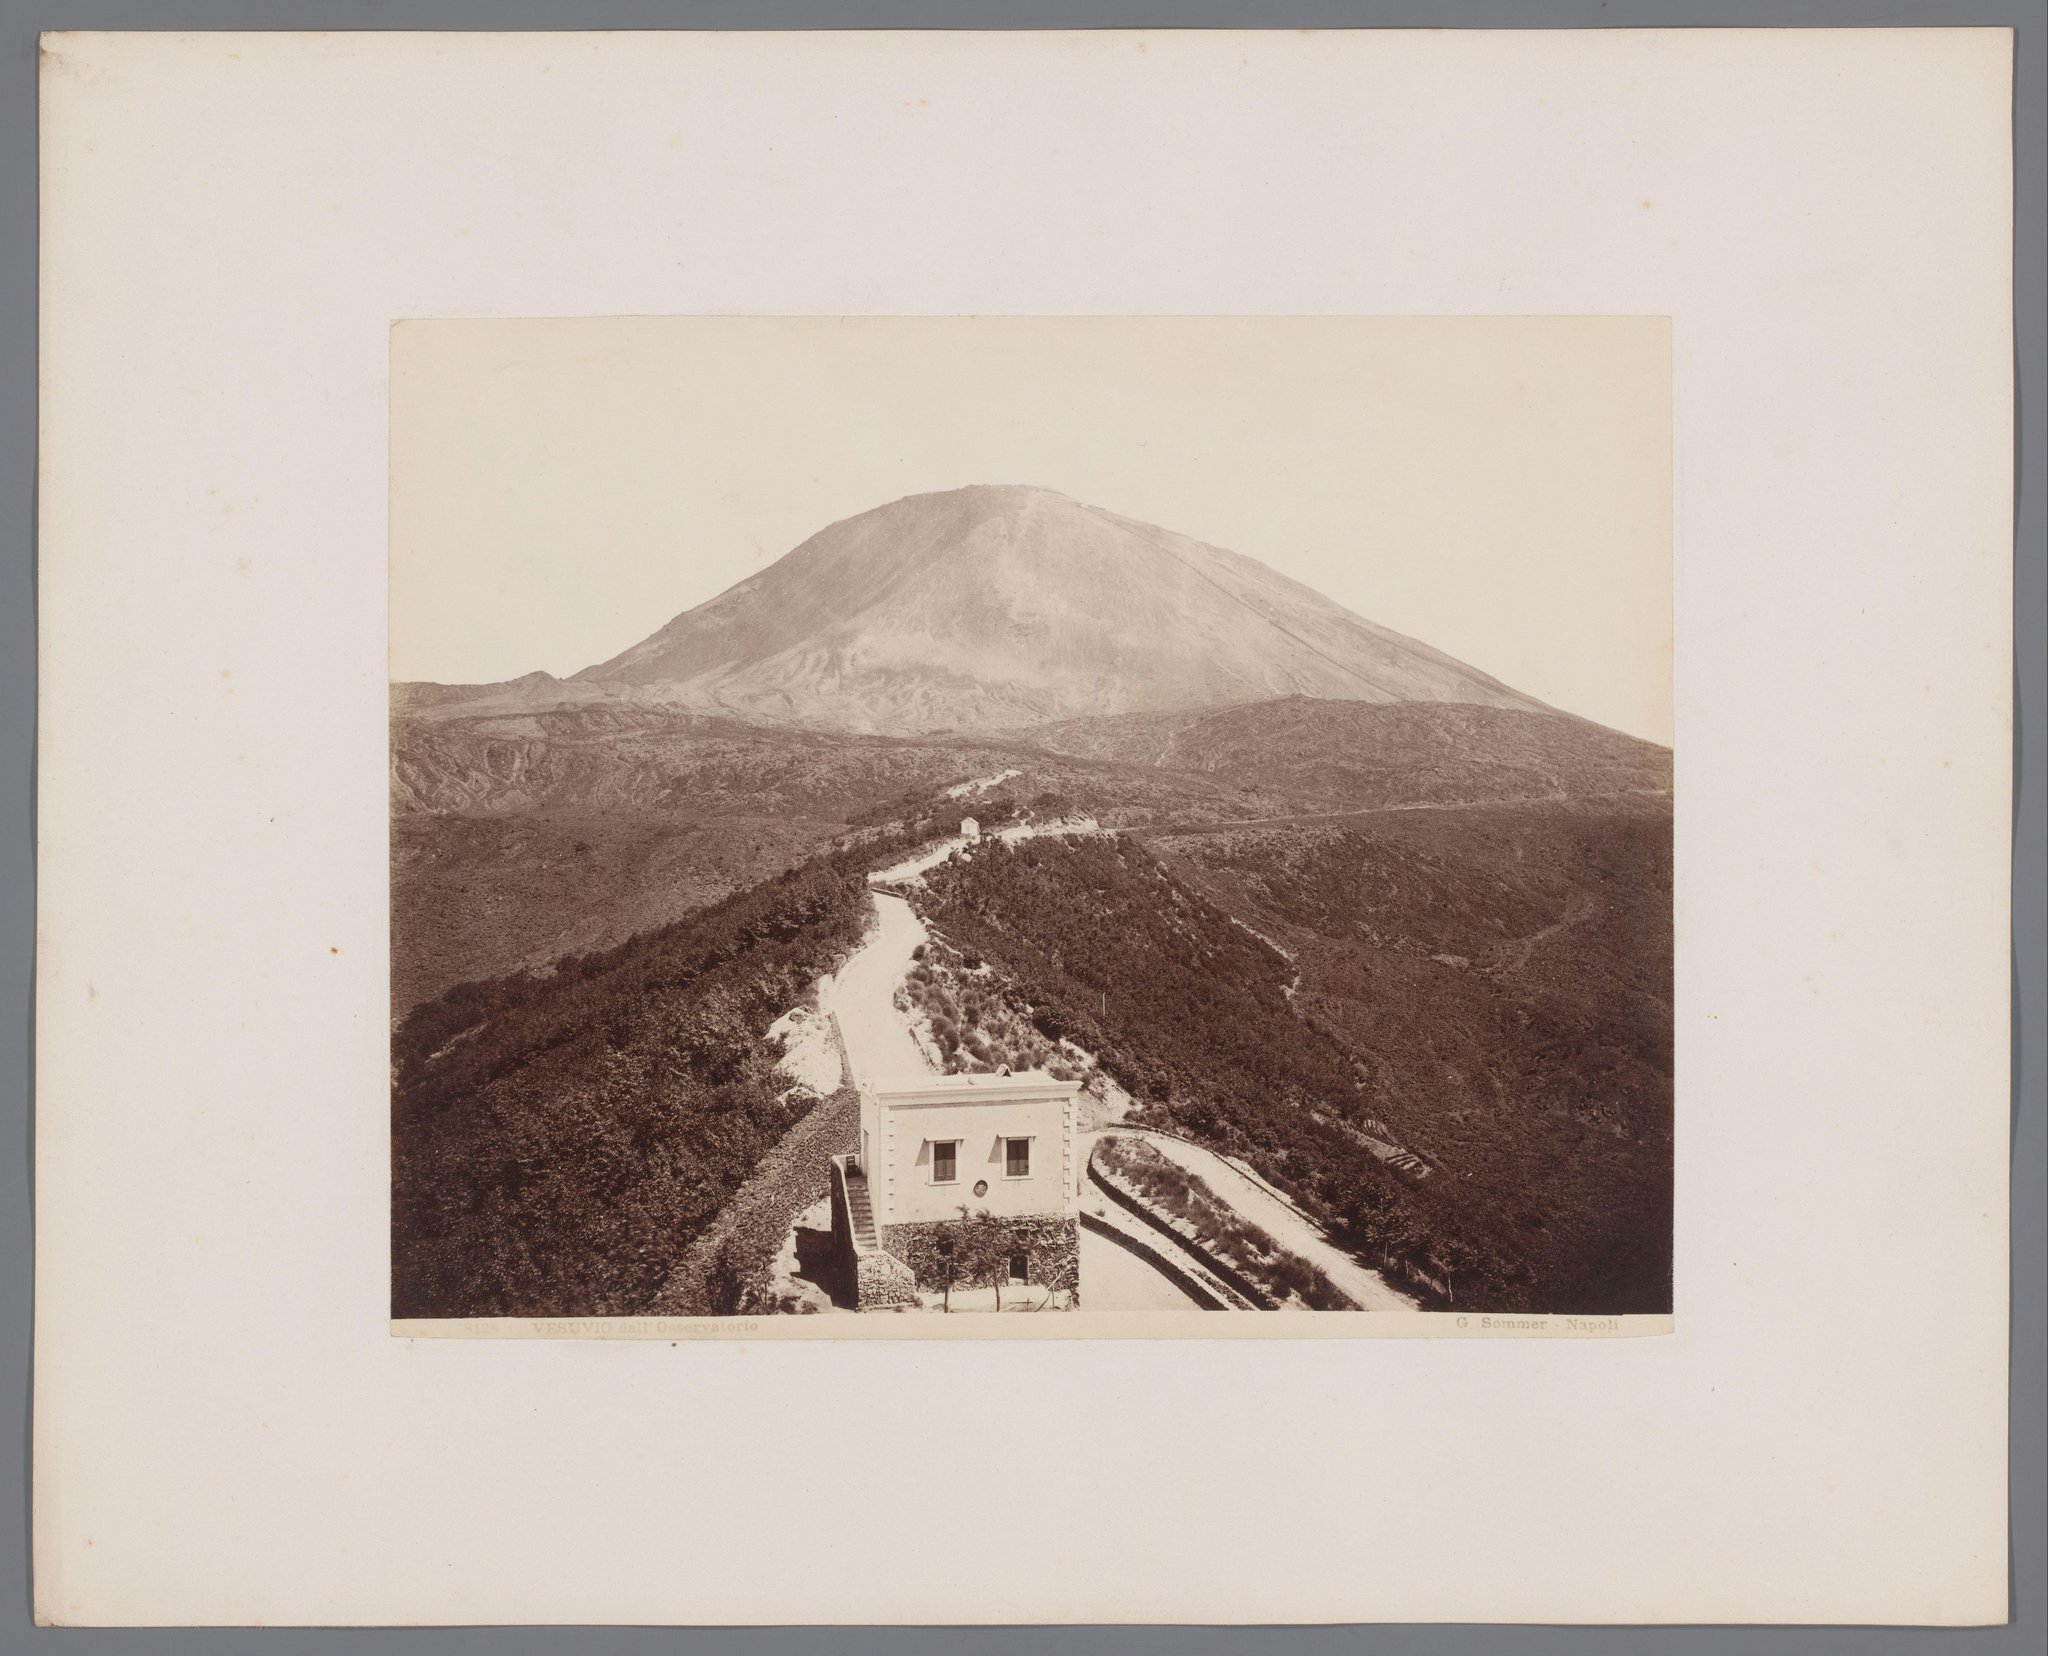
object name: photograph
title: Dall'Osservatorio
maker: giorgio sommer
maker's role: fotograaf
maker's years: 1834-1914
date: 1857-1914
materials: cardboard, paper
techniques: albumen print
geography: naples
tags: volcano, mount vesuvius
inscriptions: number: ‘8128’